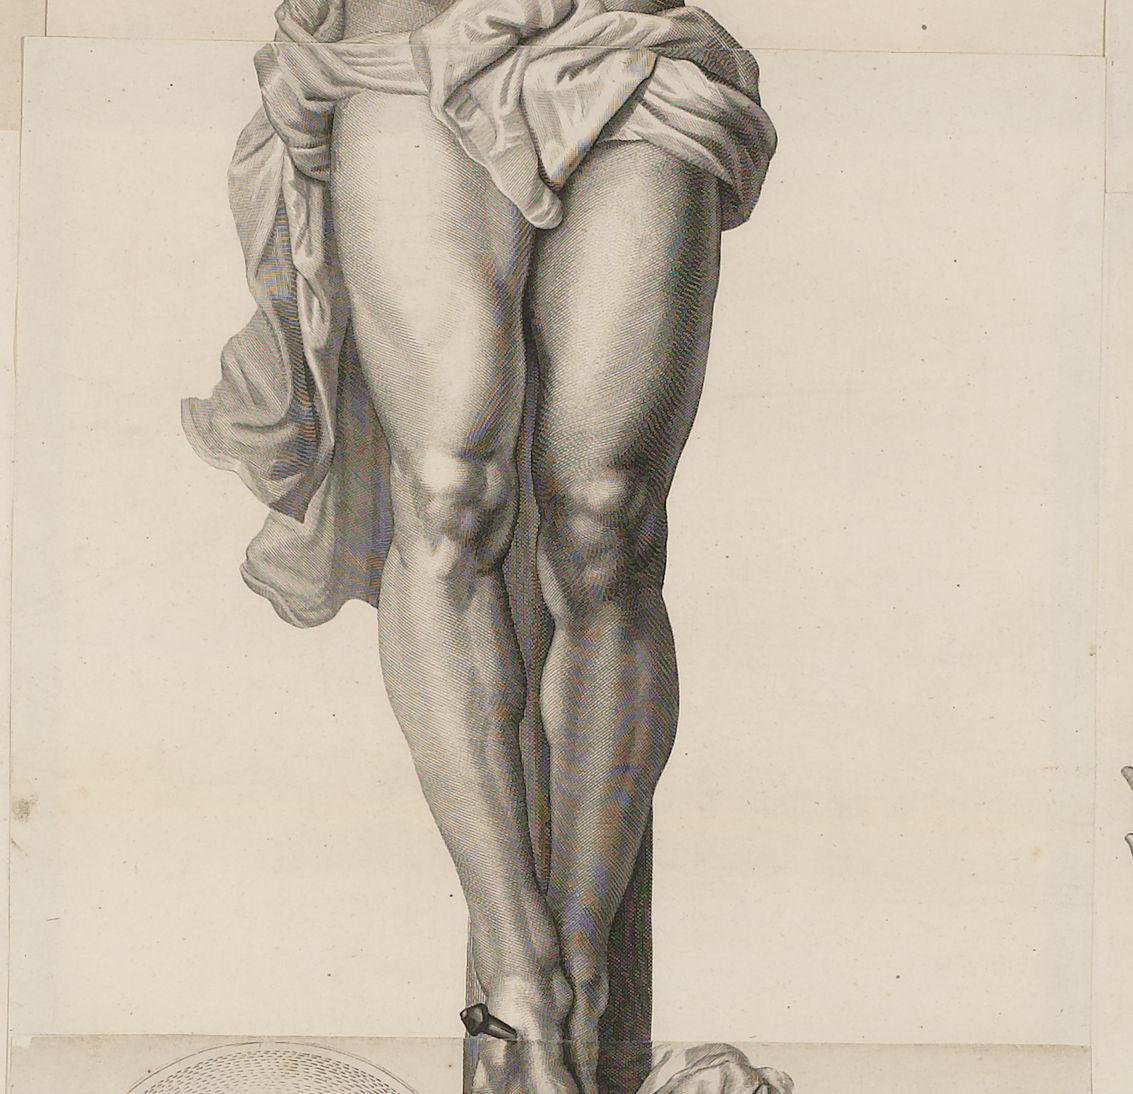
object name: print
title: Gekruisigde Christus met Maria, Johannes en Maria Magdelena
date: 1650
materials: paper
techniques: engraving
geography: antwerp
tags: crucified christ with mary, john, and mary magdalene, cupids: 'amores', 'amoretti', 'putti'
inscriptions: collector's mark: Lugt 1838, collector's mark: Lugt 240